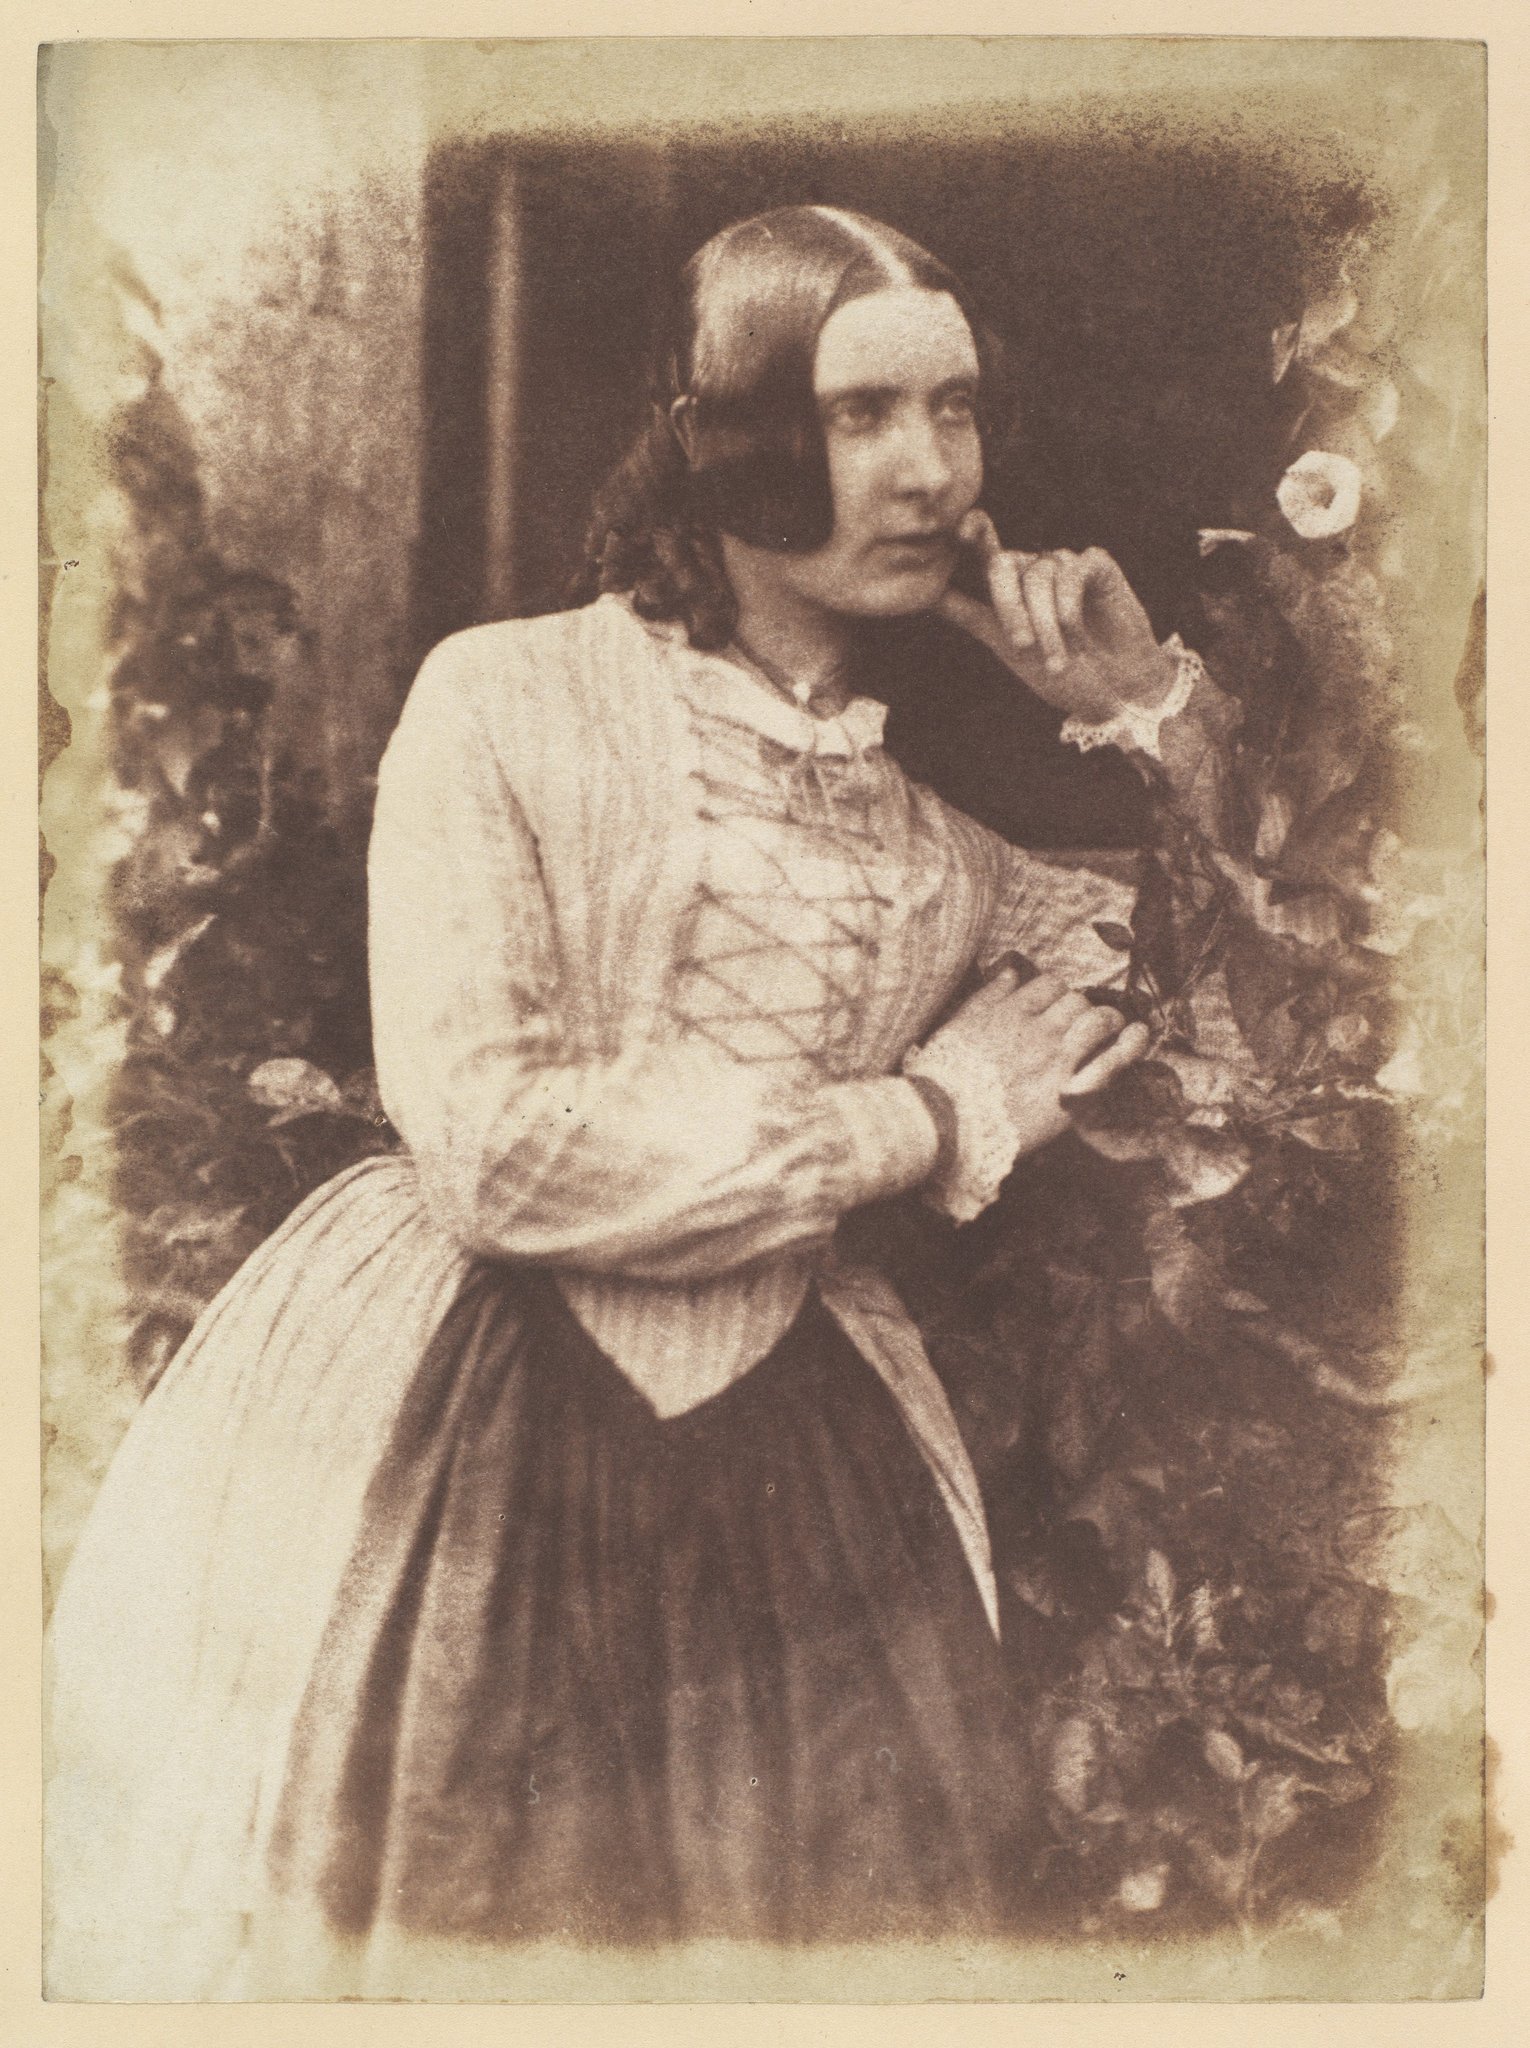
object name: photograph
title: Miss Patricia Morris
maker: hill and adamson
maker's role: artist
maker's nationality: british, scottish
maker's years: 1843-1848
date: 1843-1847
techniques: salted paper print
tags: portraits,women